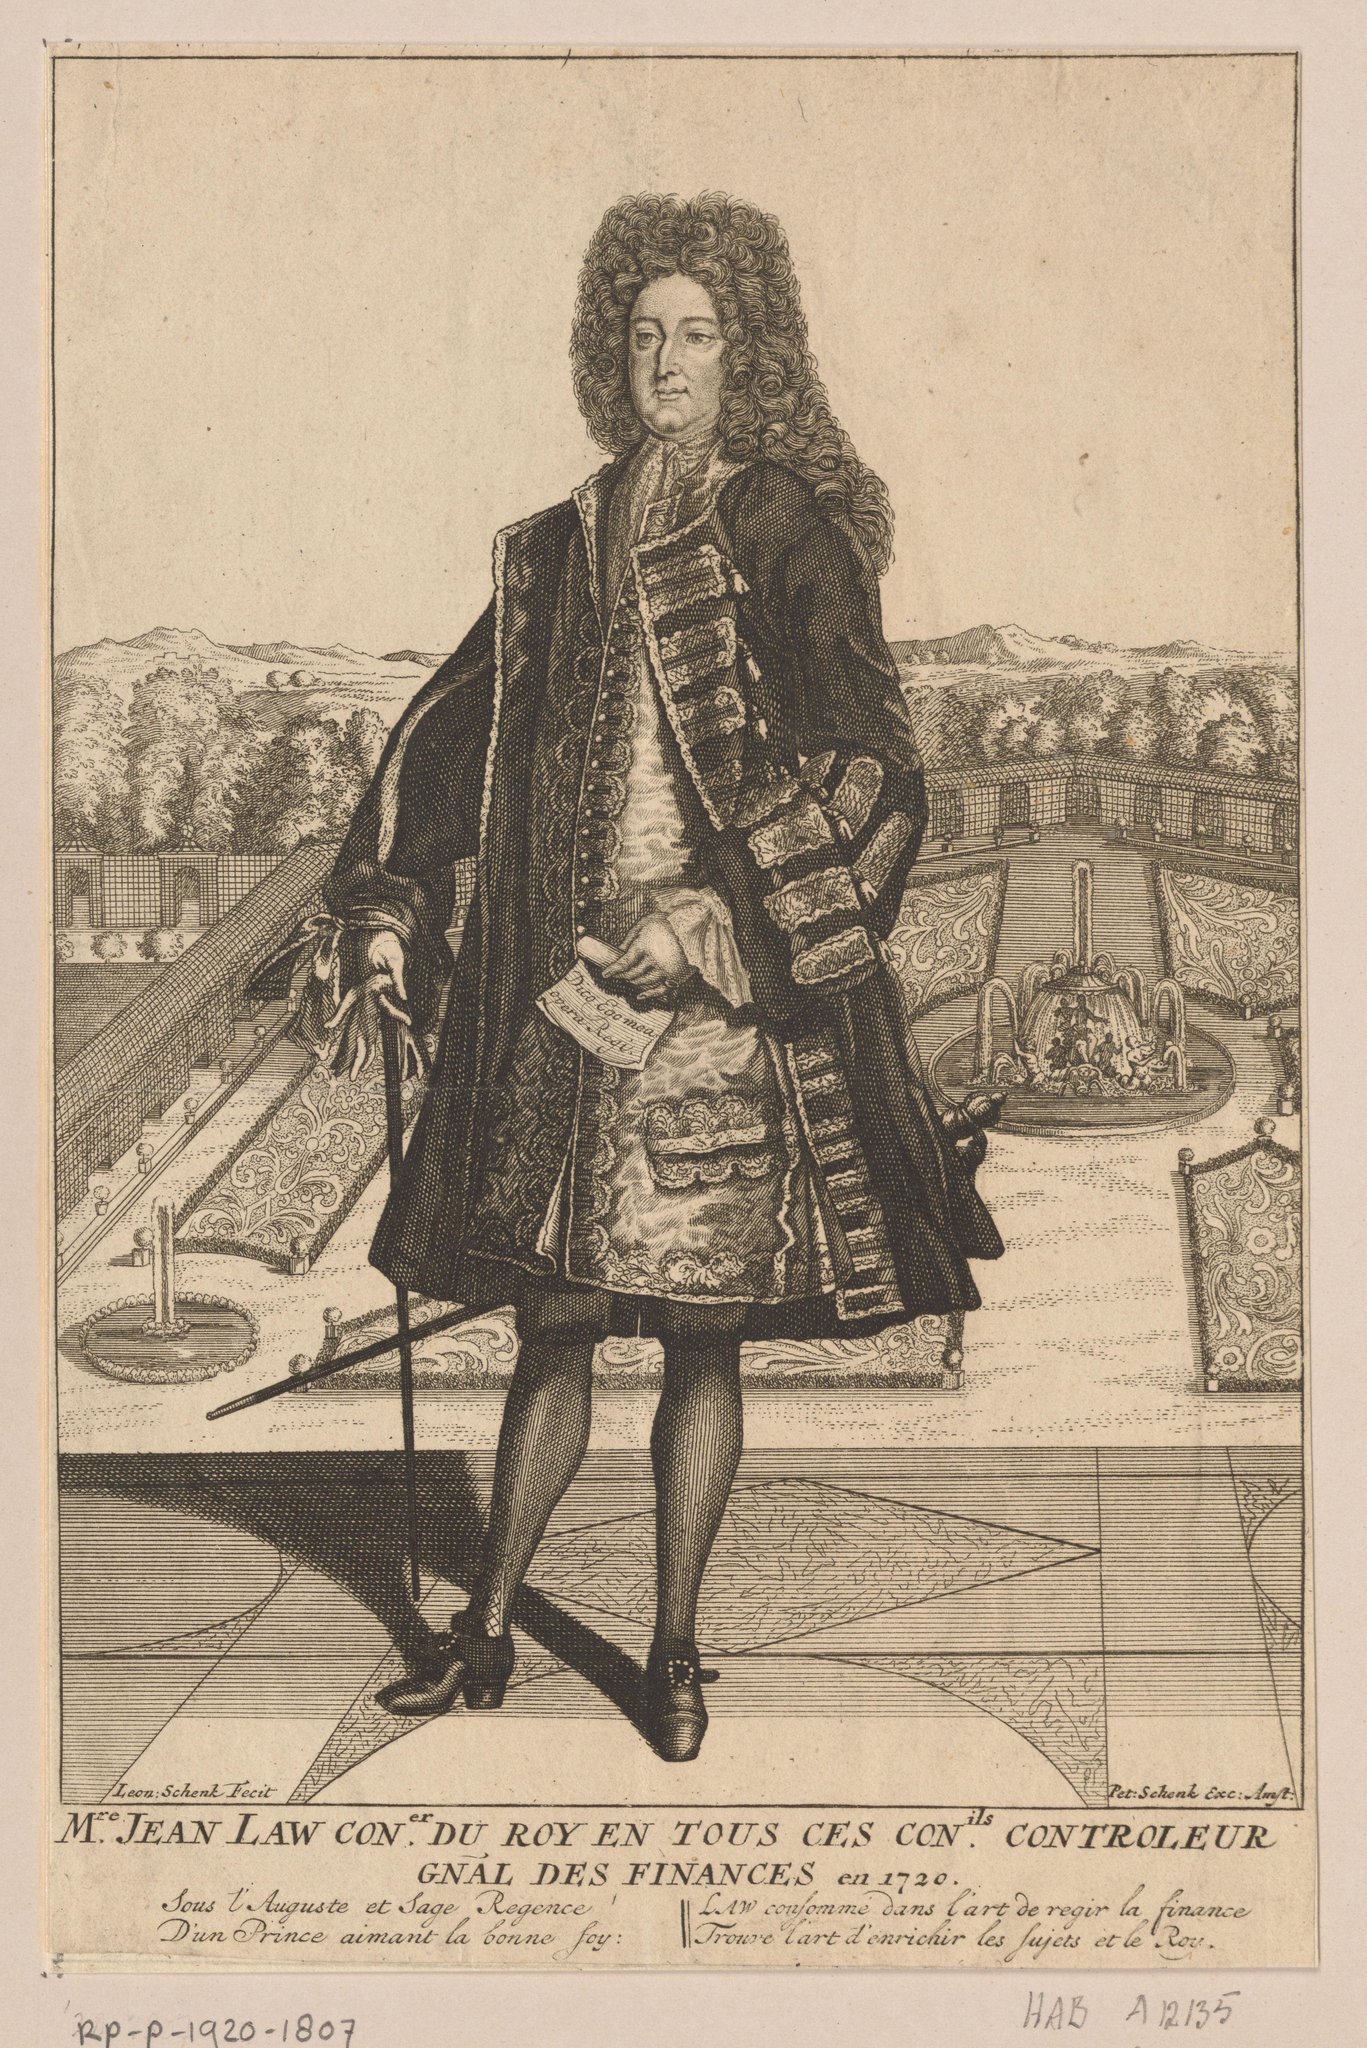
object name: cartoon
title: Portret van John Law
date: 1720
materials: paper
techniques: etching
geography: amsterdam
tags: speculative boom, historical persons, french or architectonic garden; formal garden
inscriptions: collector's mark: Lugt 2228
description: Prent waarschijnlijk uit: Het groote Tafereel der Dwaasheid, vertoonende de opkomst, voortgang en ondergang der Actie, Bubbel en Windnegotie in Vrankryk, Engeland, en de Nederlanden (...). S.l.s.n., 1720.